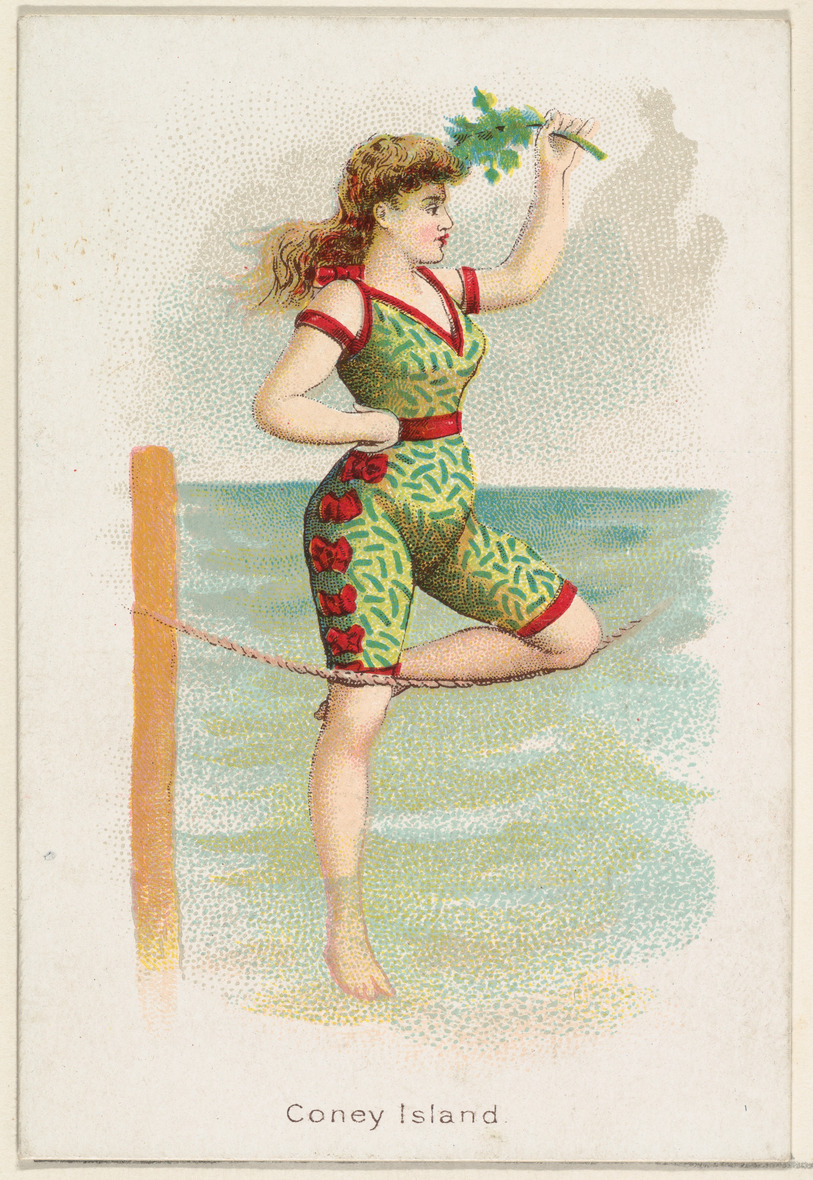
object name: print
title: Coney Island, from the Beautiful Bathers series (N192) issued by Wm. S. Kimball & Co.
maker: william s. kimball & company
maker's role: publisher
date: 1889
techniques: color lithograph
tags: profiles,women